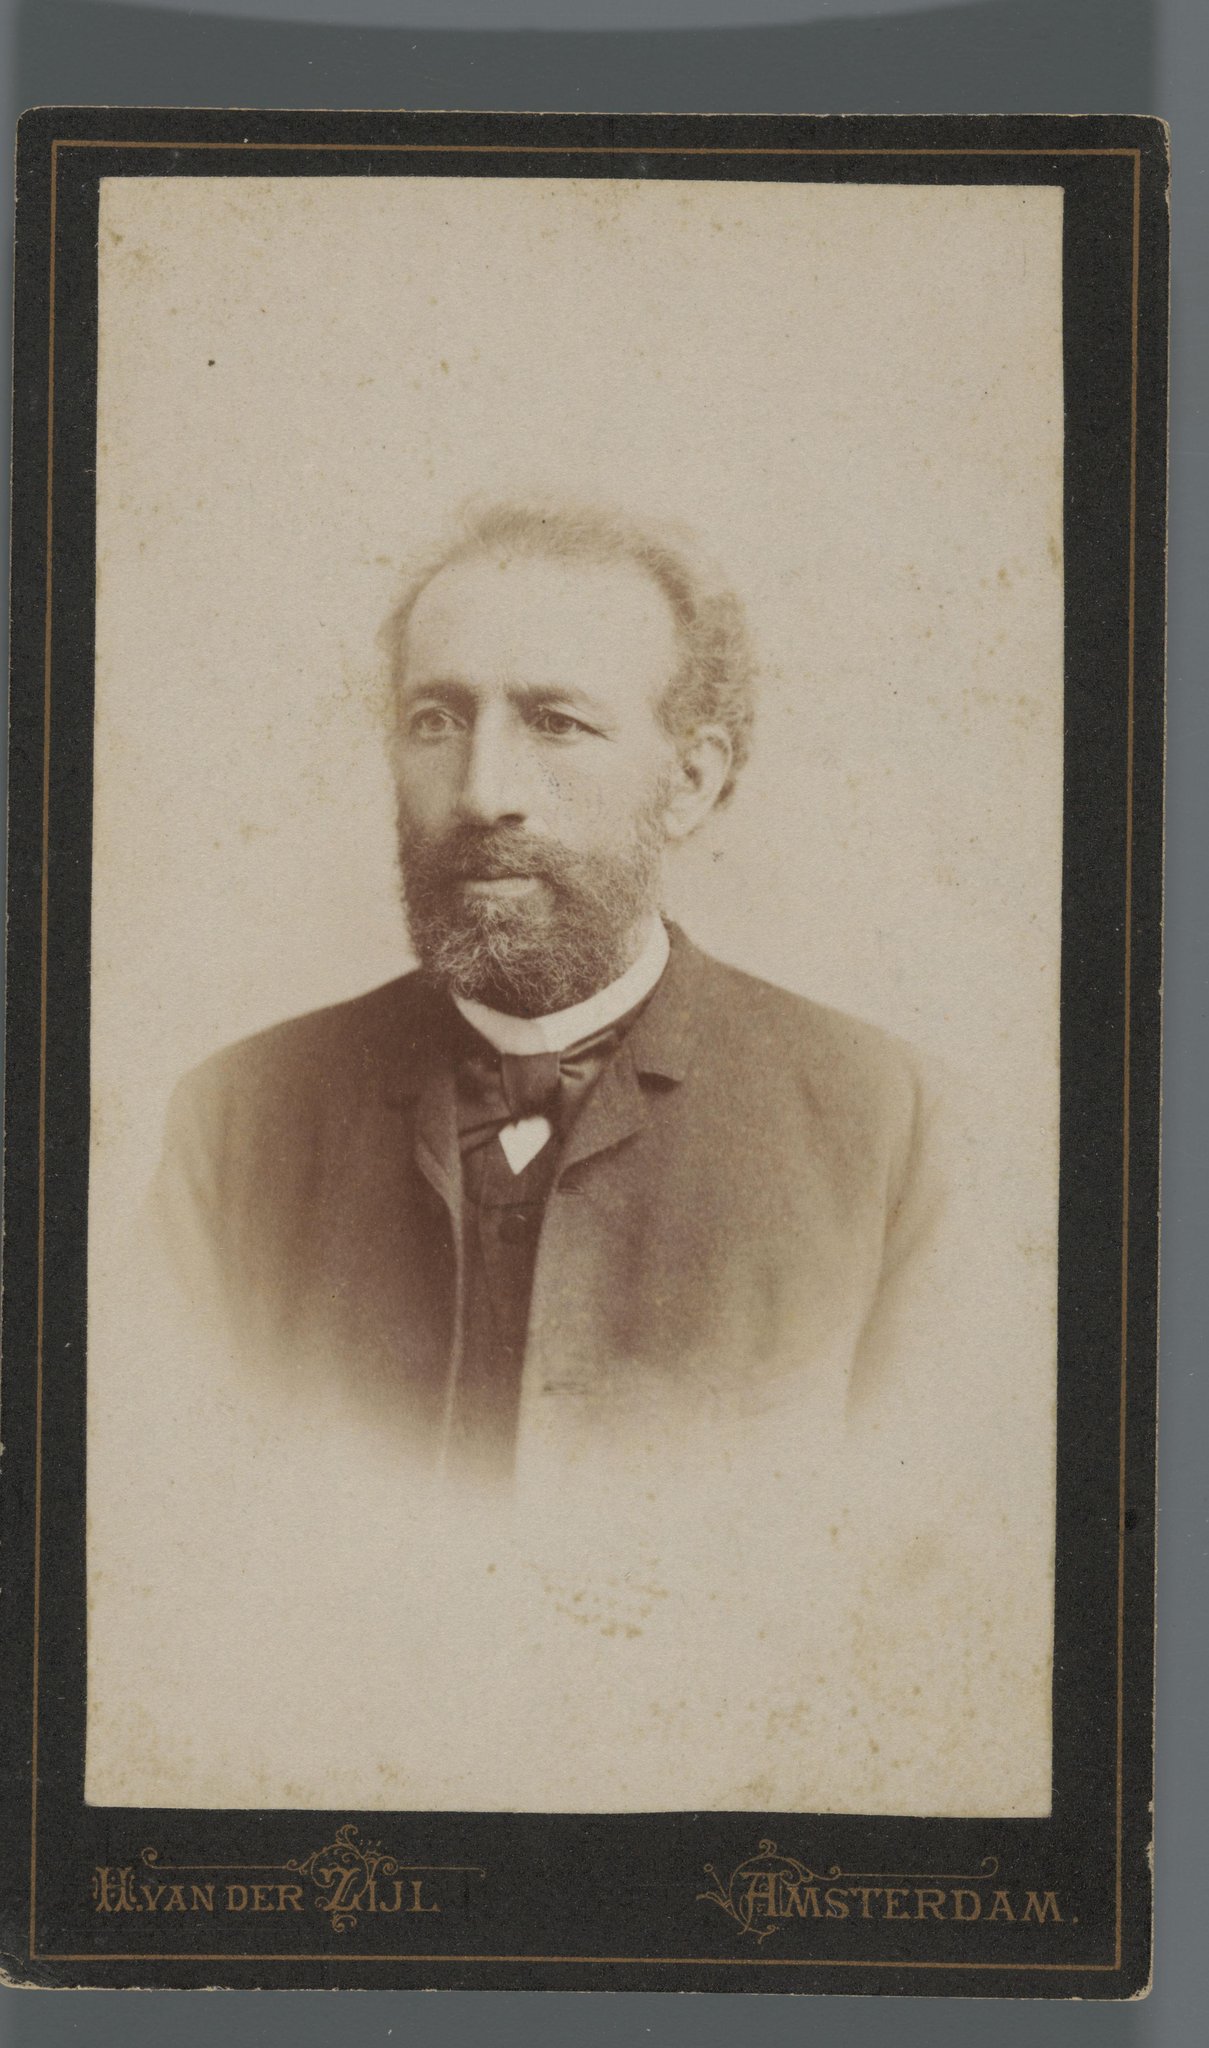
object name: carte de visite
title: Portret van een man uit de familie Marmelstein, vermoedelijk de vader van A. F. Marmelstein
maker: h. van der zijl jr.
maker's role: fotograaf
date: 1850-1900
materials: cardboard, photographic support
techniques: albumen print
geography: amsterdam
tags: adult man, historical persons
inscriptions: retailer's mark: ‘Photographie/ Parisienne/ (...)’